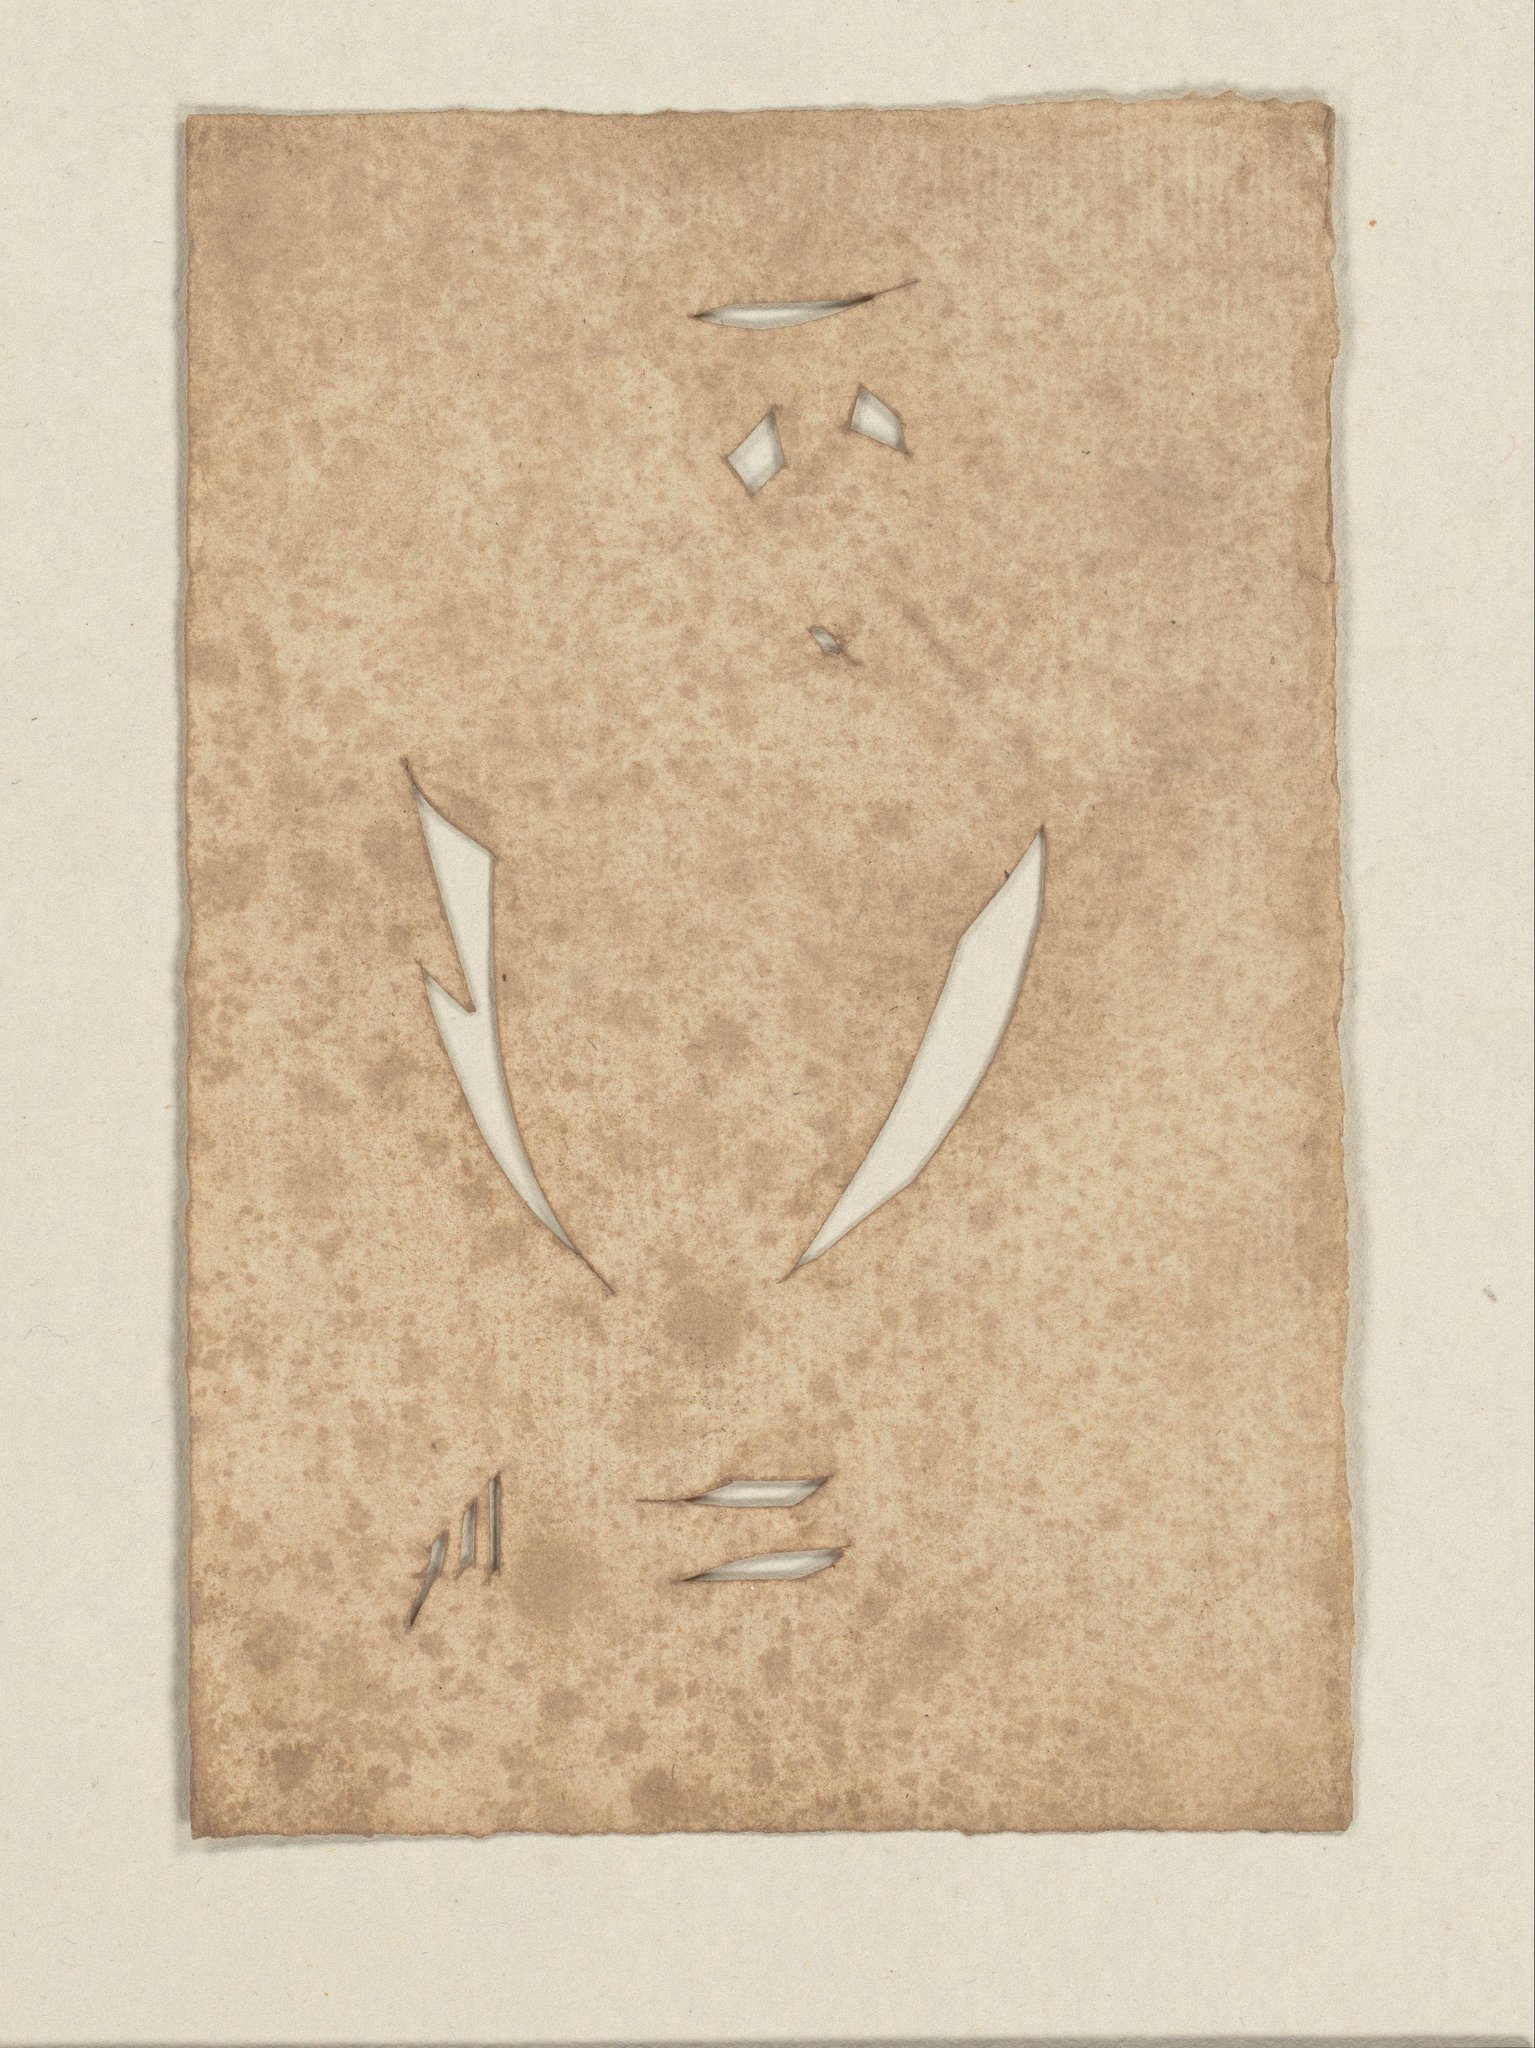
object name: drawing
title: Sjabloon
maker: cornelis ploos van amstel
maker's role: draughtsman, print maker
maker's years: 1726-1798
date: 1736-1798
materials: paper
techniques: snipping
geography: amsterdam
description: Het sjabloon ligt los achterin een album.